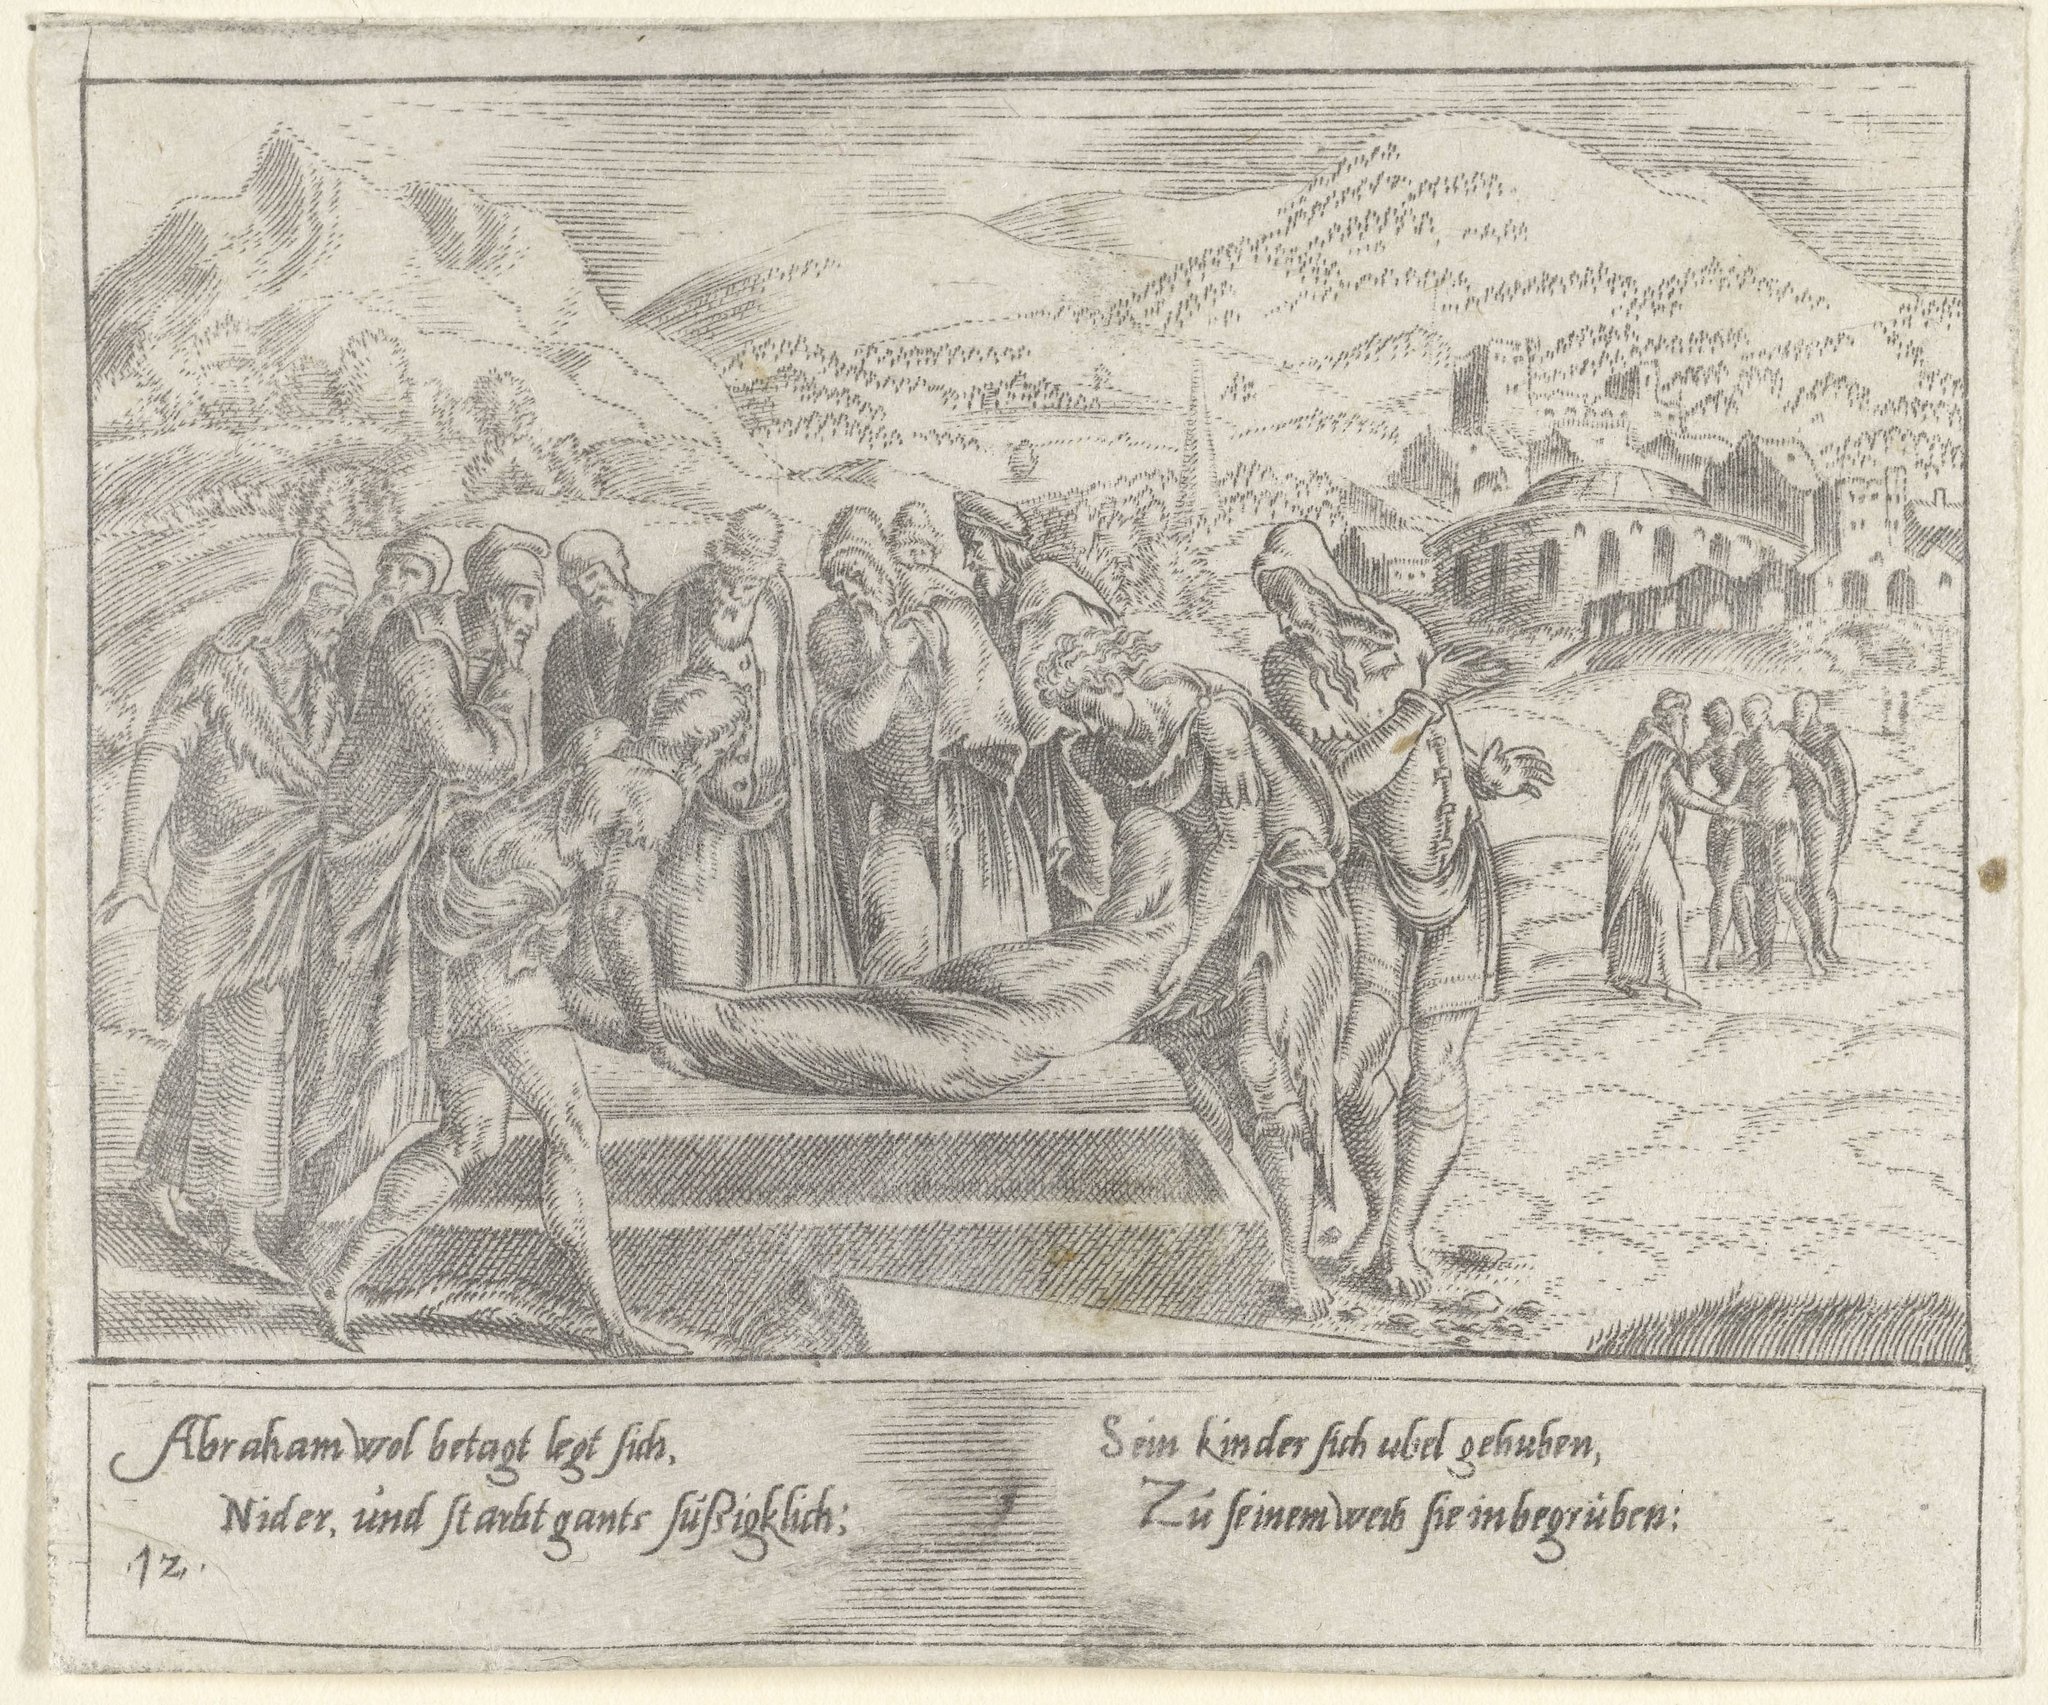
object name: print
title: Begrafenis van Abraham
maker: cornelis bos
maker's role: print maker, printer, publisher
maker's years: 1510-1566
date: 1555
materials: paper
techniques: engraving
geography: groningen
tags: abraham is buried by isaac and ishmael in the cave of machpelah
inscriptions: collector's mark: Lugt 2228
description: Abraham wordt door zijn twee zonen Isaak en Ismaël begraven in zijn graf in Machpela waar ook zijn vrouw Sara al begraven ligt. Prent uit een serie van 12 prenten met het leven van Abraham. Alle prenten hebben vier regels Duitse verklarende tekst in de ondermarge.